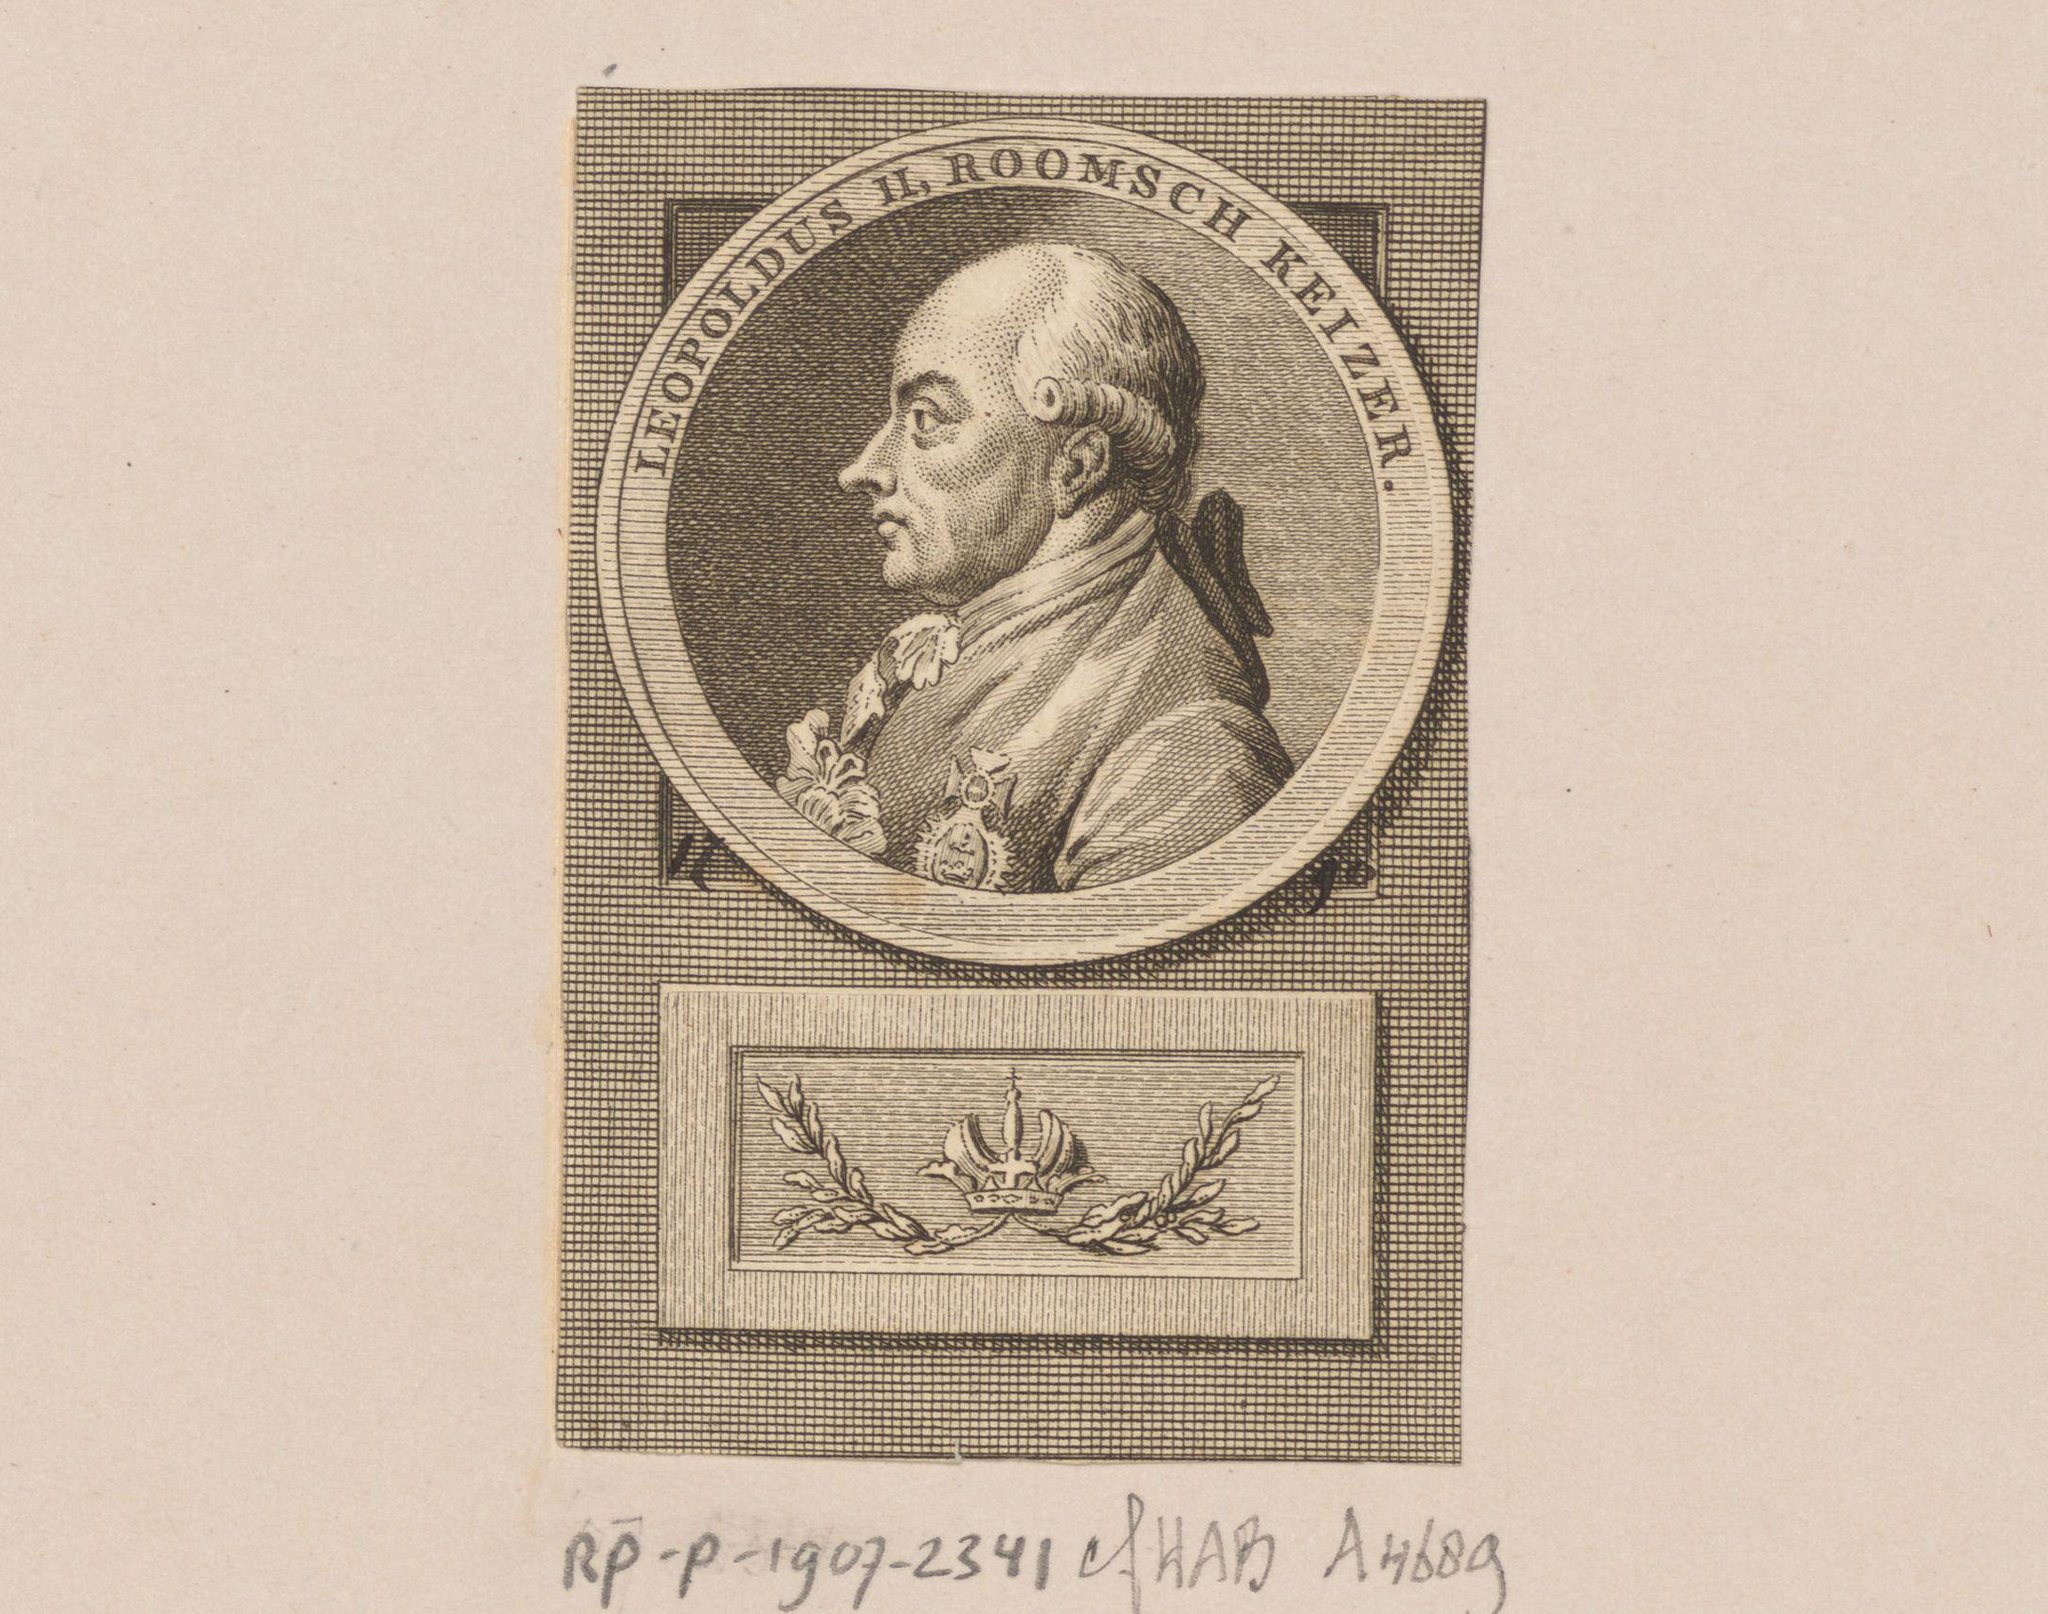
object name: print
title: Portret van keizer Leopold II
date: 1793-1794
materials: paper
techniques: etching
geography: amsterdam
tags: vienna, leopold ii (keizer van oostenrijk), crown (symbol of sovereignty), historical persons, emperor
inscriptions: collector's mark: Lugt 2228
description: Prent waarschijnlijk uit: Fokke, Jan. Geschiedenissen der Vereenigde Nederlanden voor de vaderlandsche jeugd. Amsterdam: Johannes Allart, 1793-1794, dl. 22.